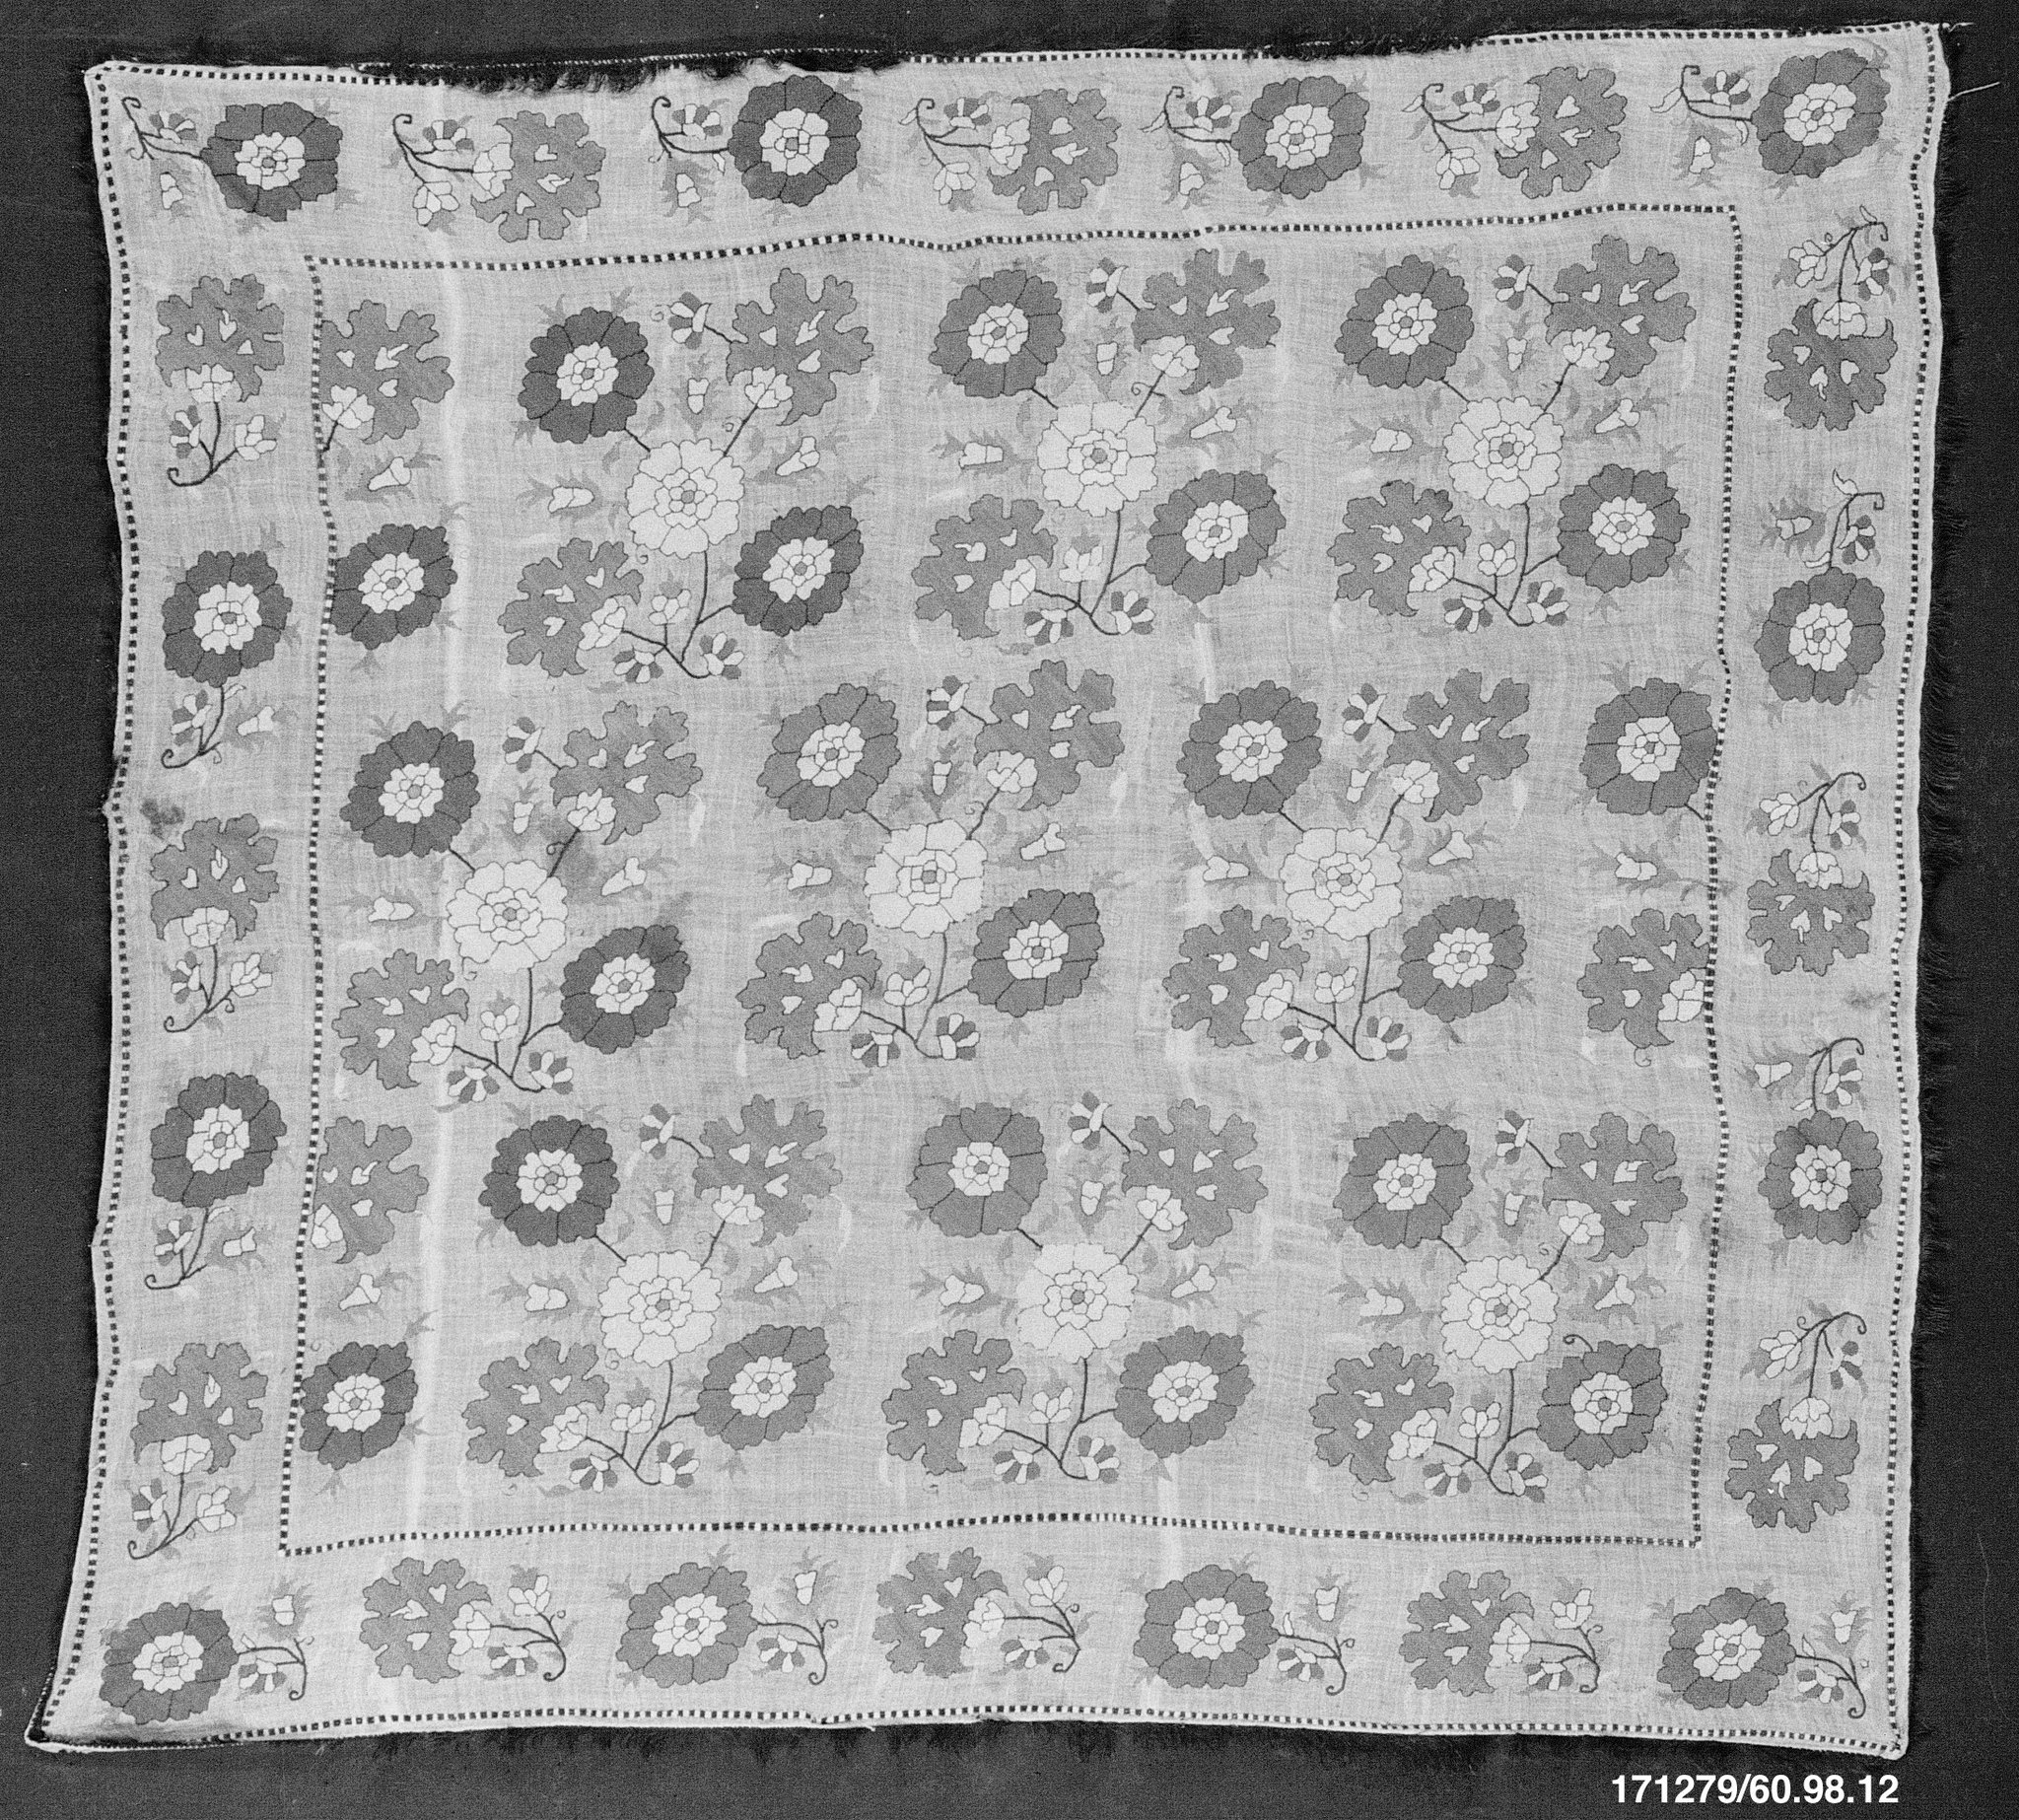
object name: square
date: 1701-1800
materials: linen, silk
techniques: embroidery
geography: algeria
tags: flowers